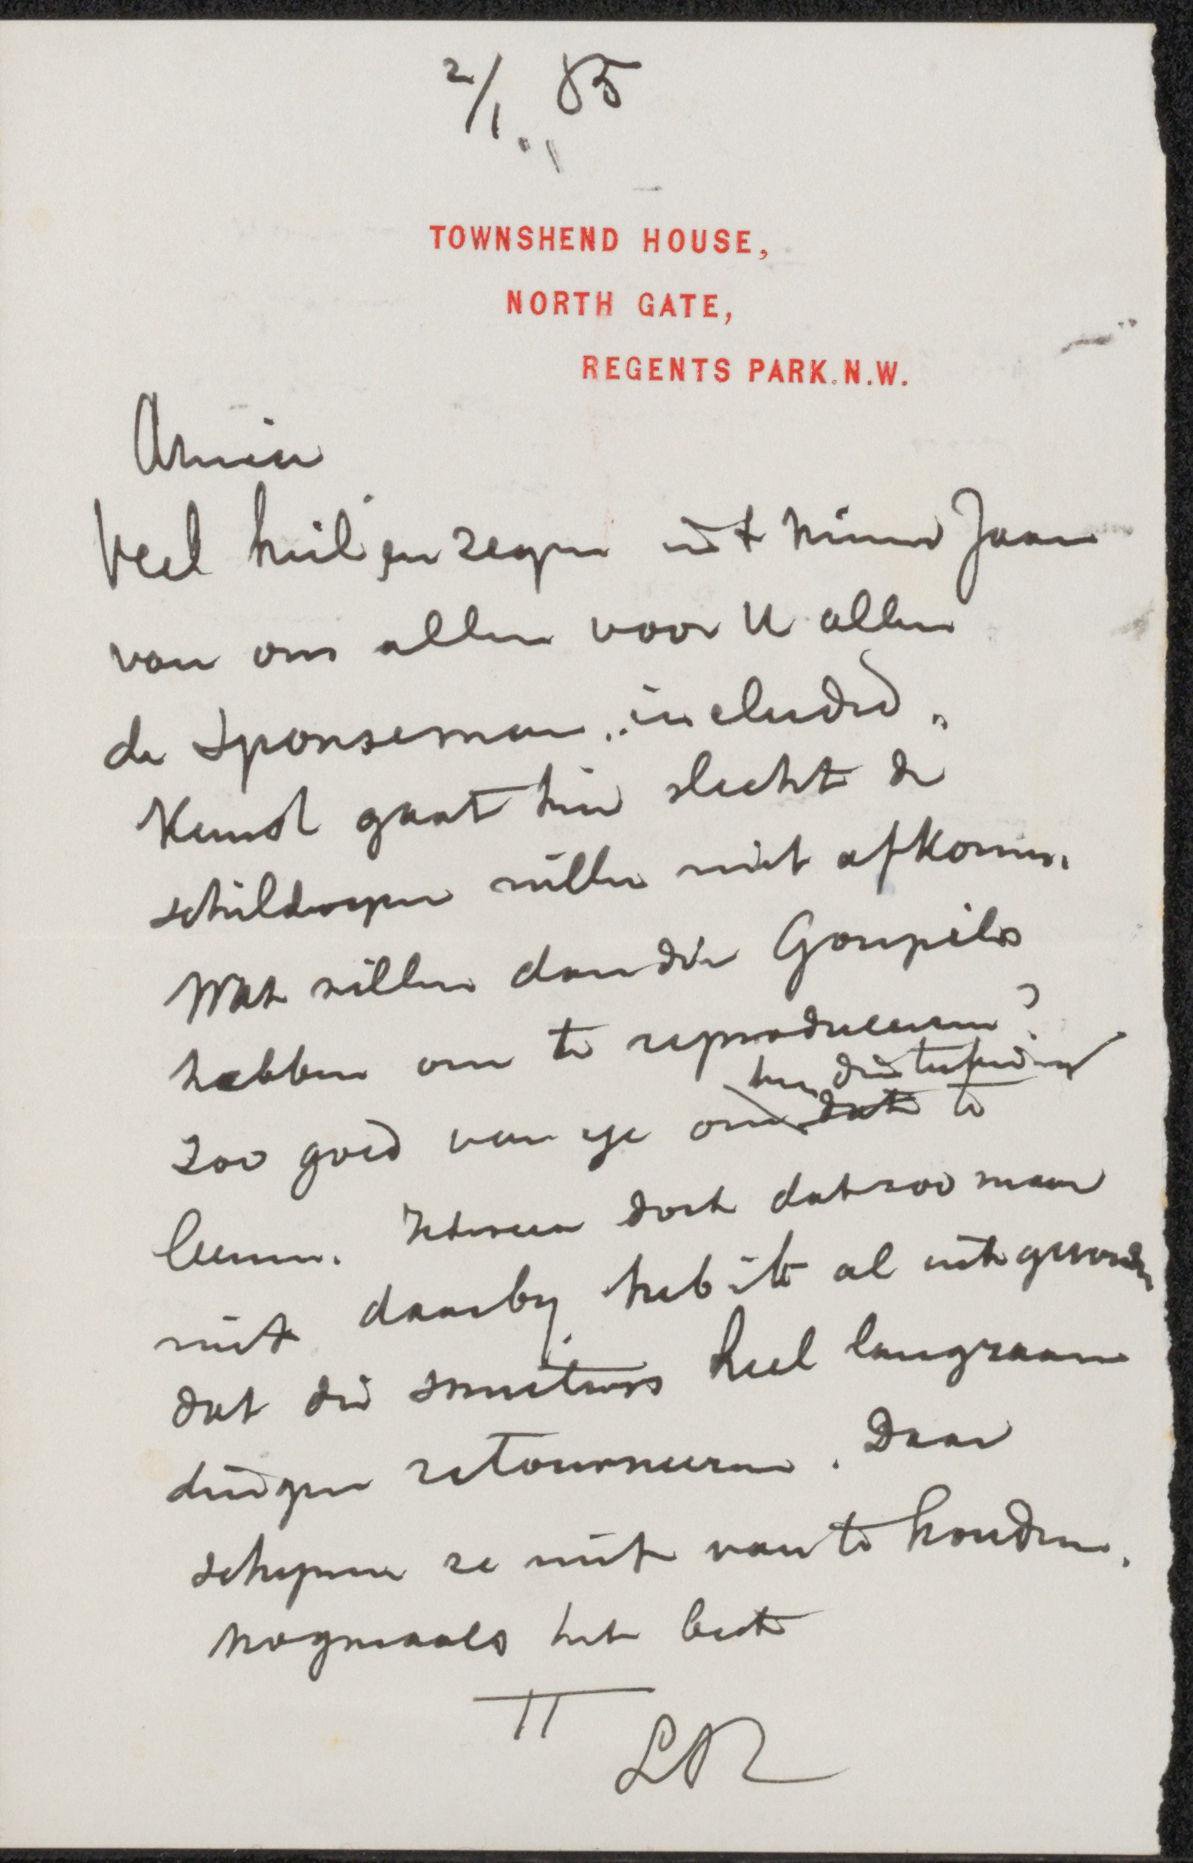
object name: letter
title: Brief aan Carel Vosmaer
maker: lourens alma tadema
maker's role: draughtsman, print maker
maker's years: 1836-1912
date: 1885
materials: ink, paper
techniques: pen, printing, writing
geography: london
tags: the hague, print maker, draughtsman, carel vosmaer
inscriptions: watermark